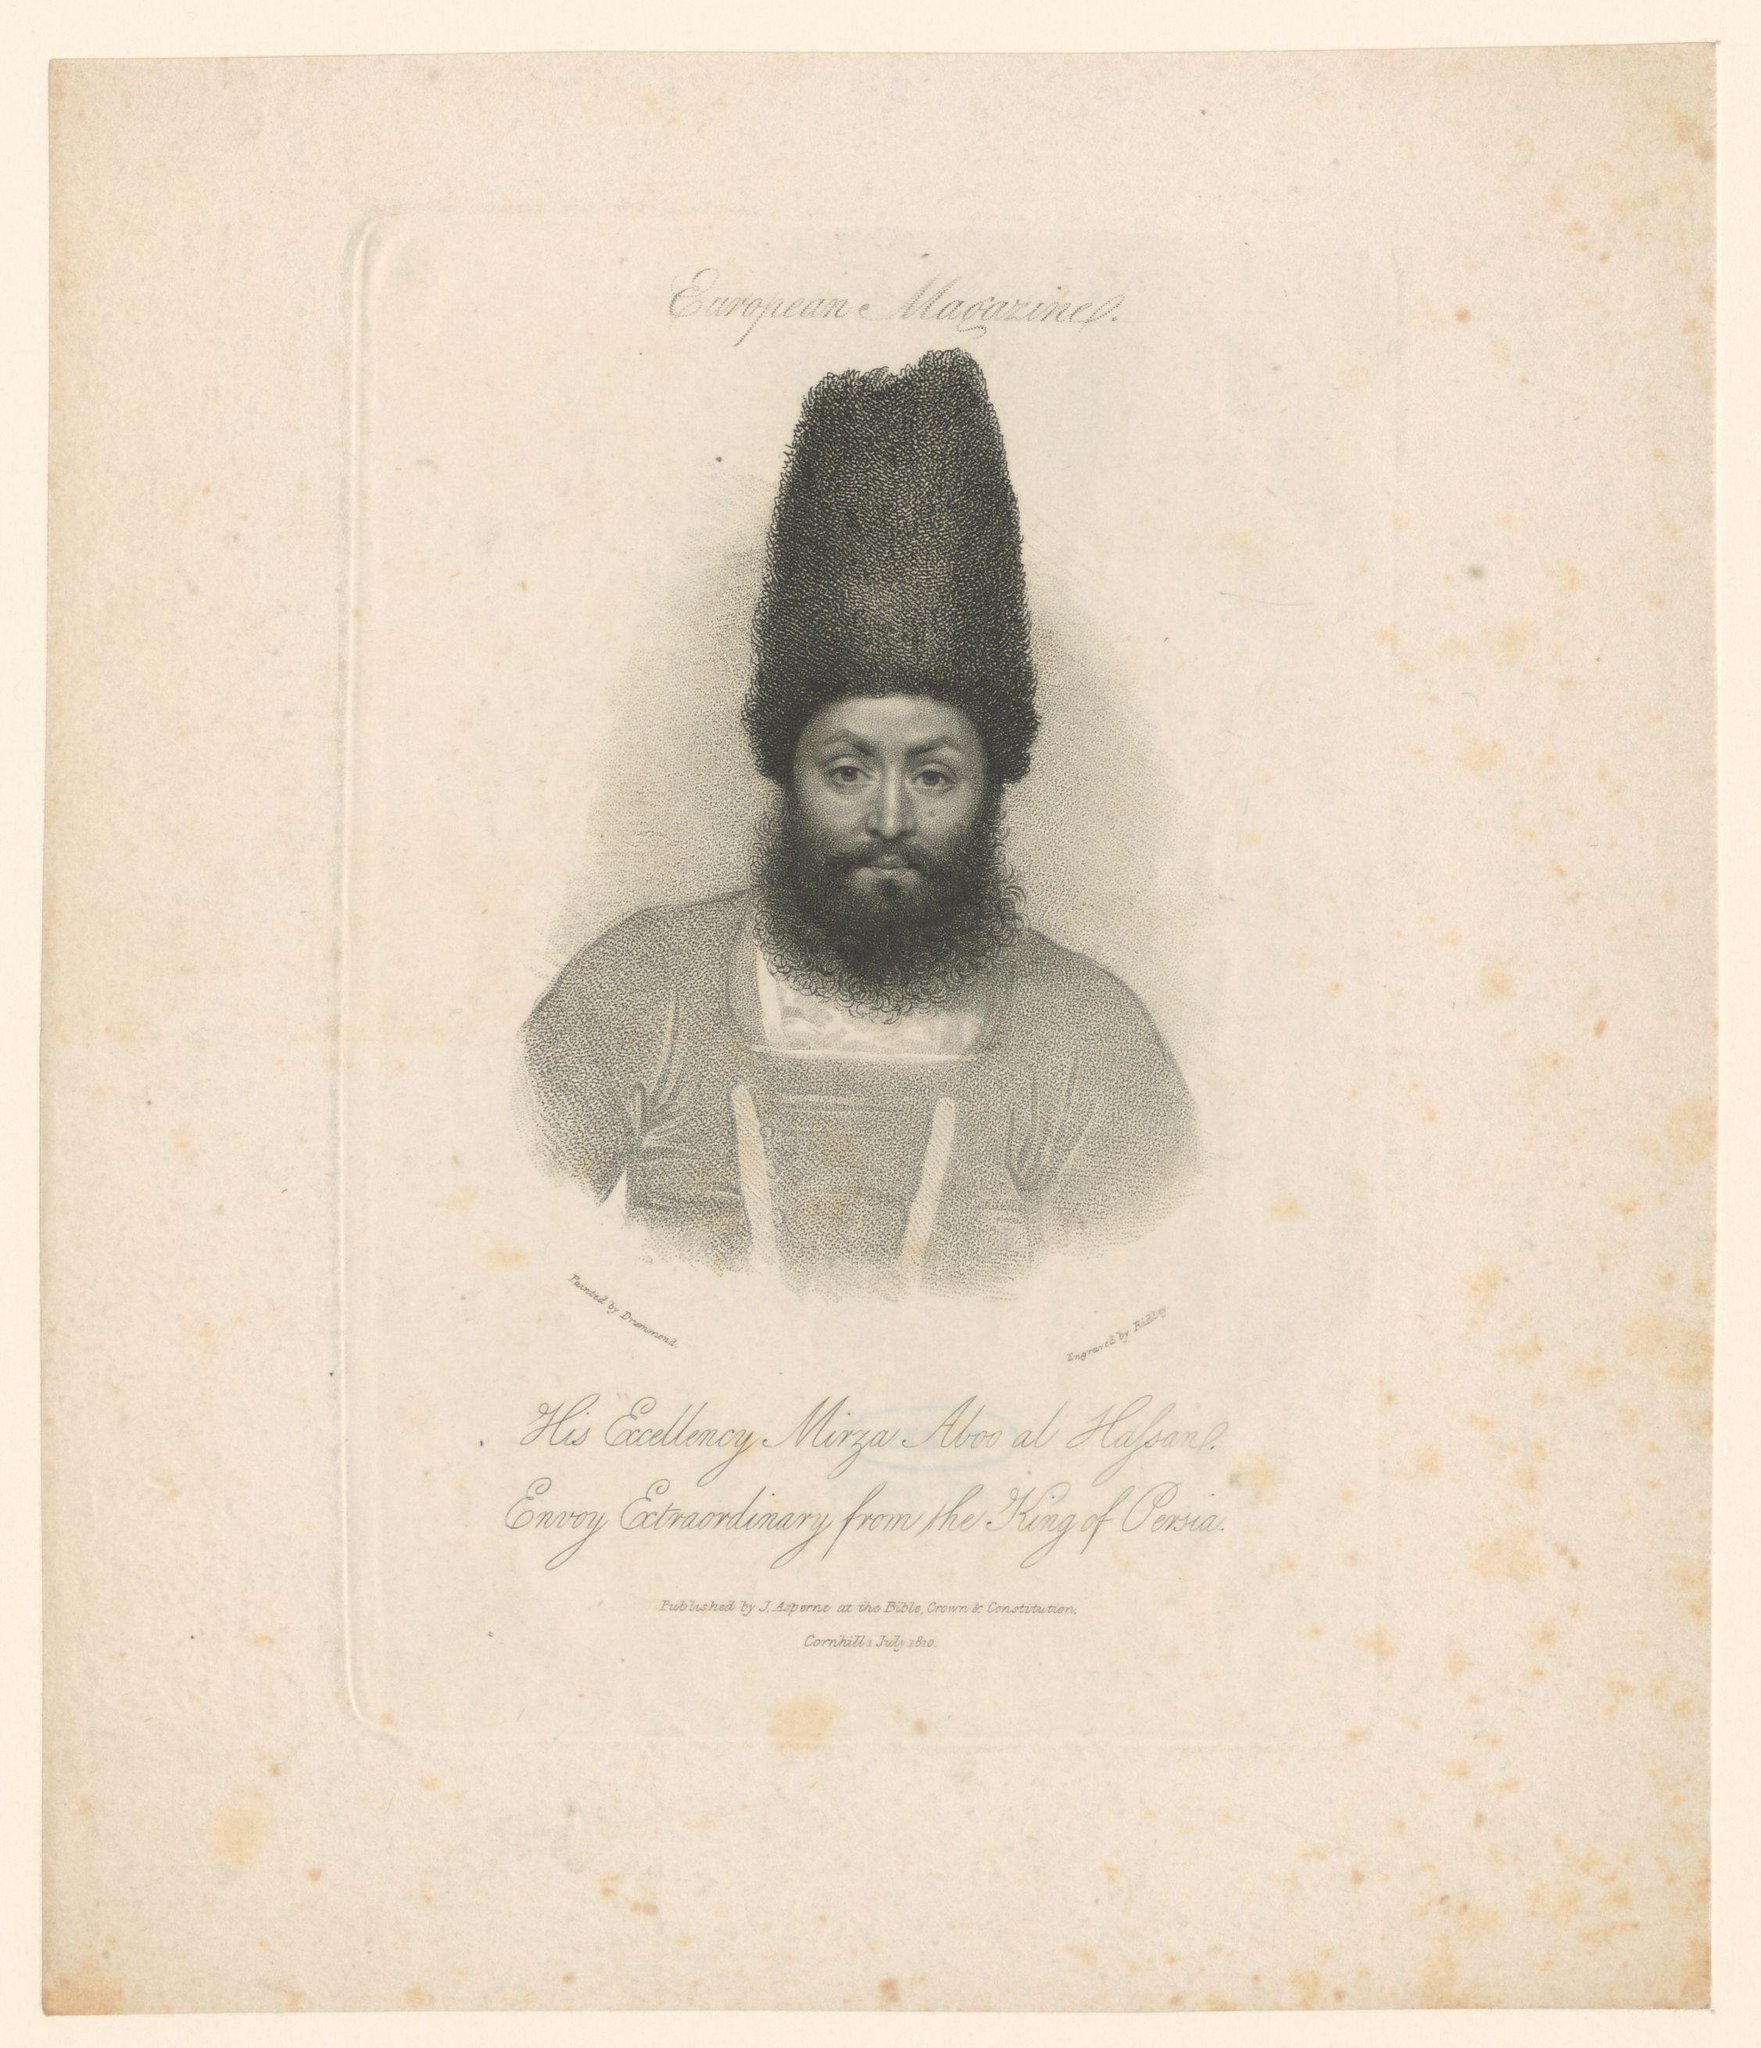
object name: print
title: Portret van Mirza Abolhassan Khan Ilchi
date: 1810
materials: paper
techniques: etching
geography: london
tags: politician, historical persons, lawyer, attorney at law, beard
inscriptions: collector's mark: Lugt 2228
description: Prent gebruikt in: European Magazine, 1810.